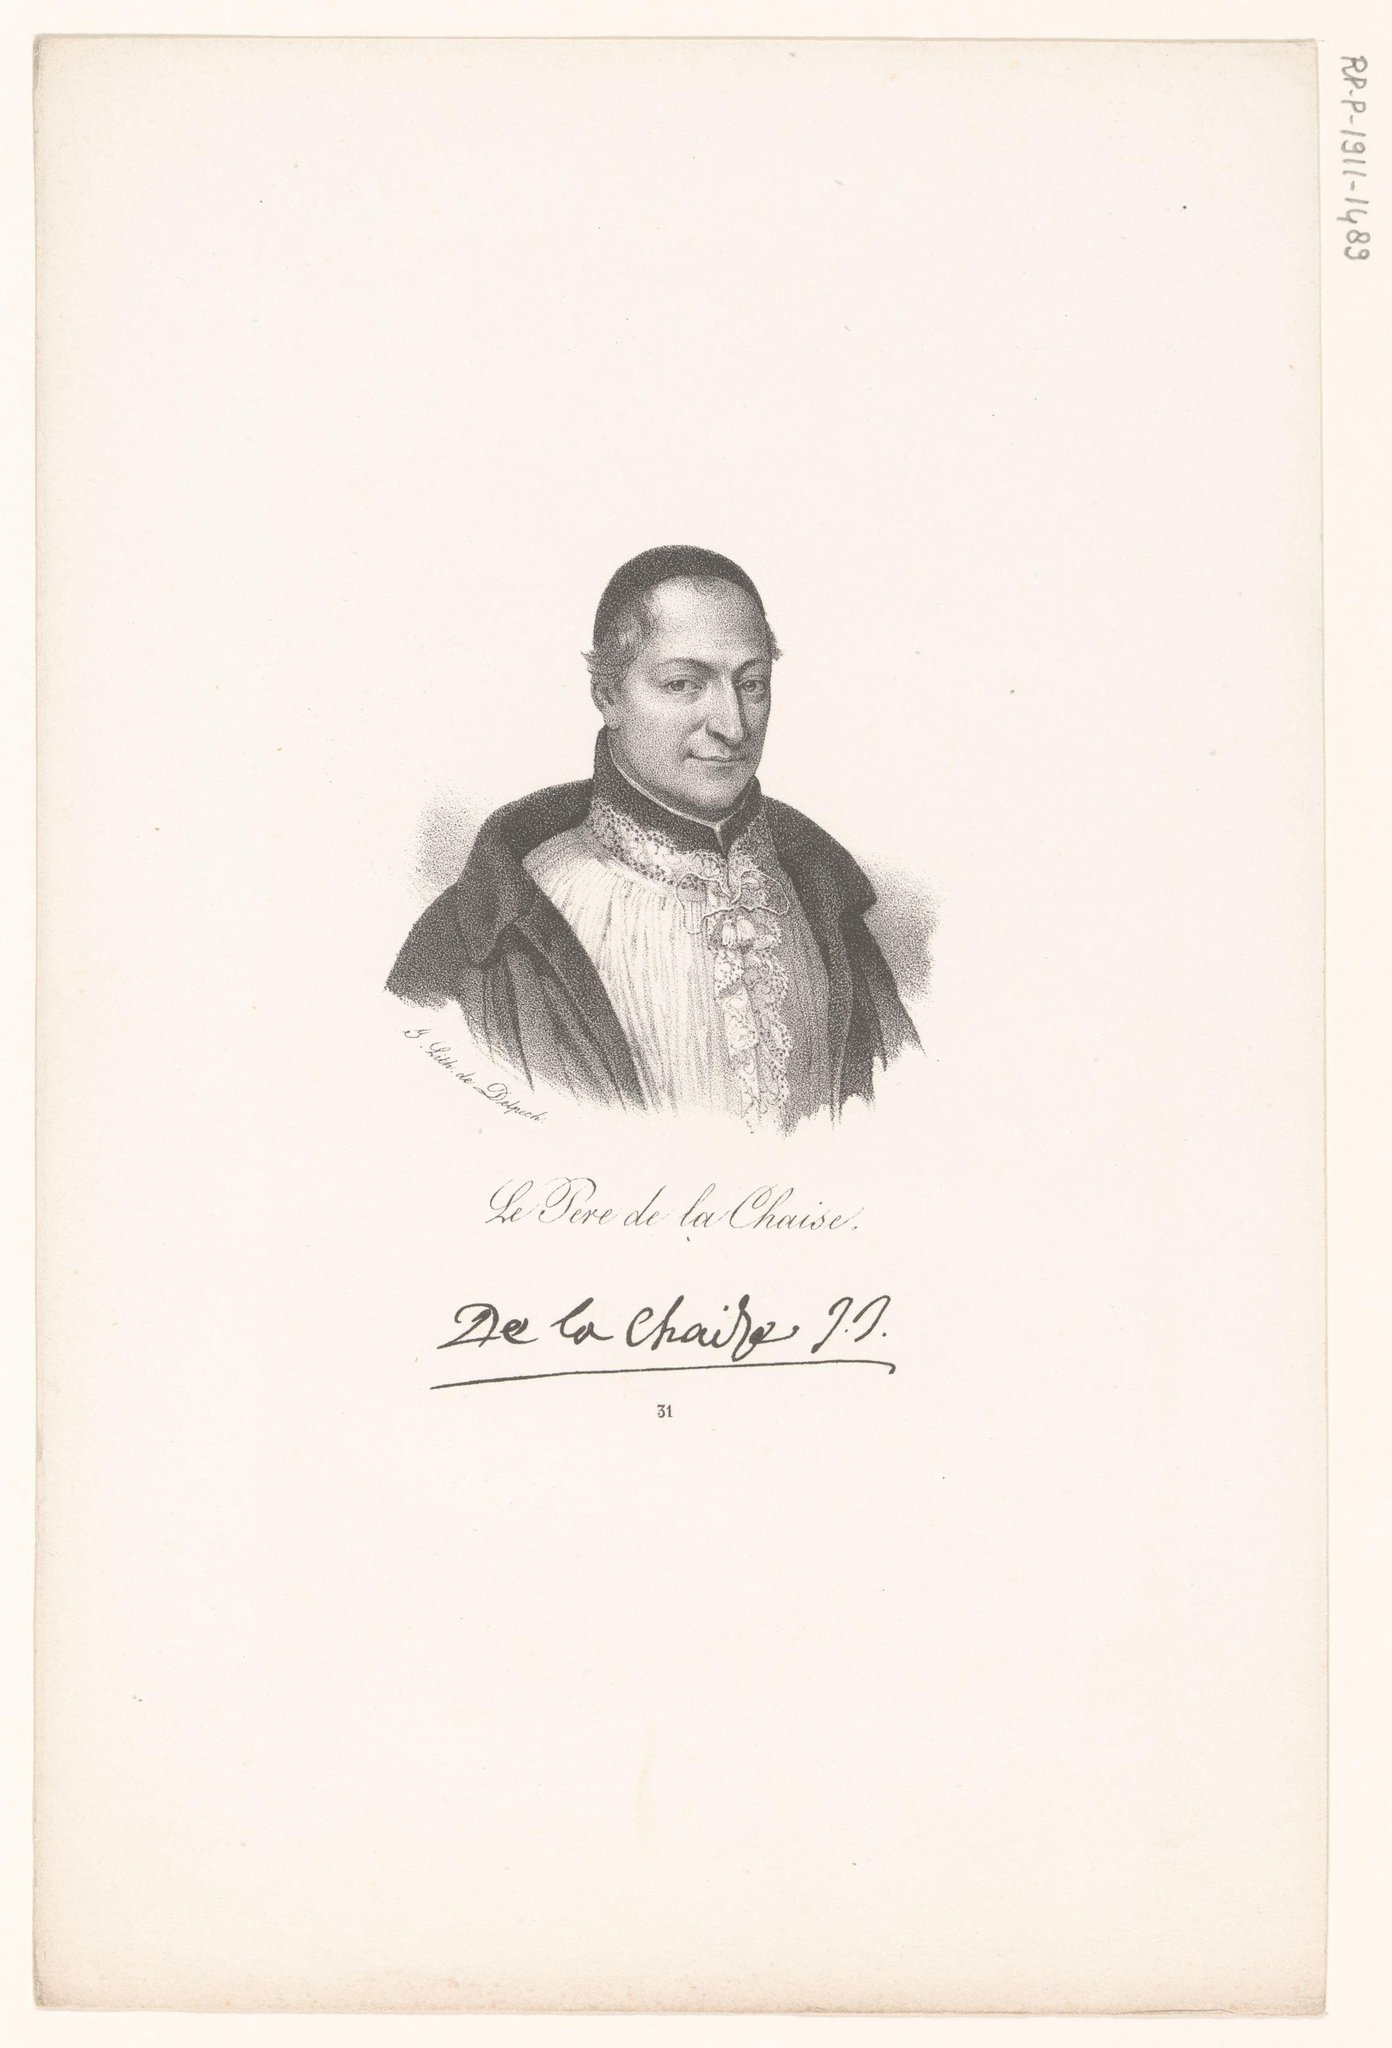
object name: print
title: Portret van François d'Aix de La Chaise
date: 1818-1842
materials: paper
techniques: lithograph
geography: paris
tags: paris, clergyman, historical persons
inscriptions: collector's mark: Lugt 2228a